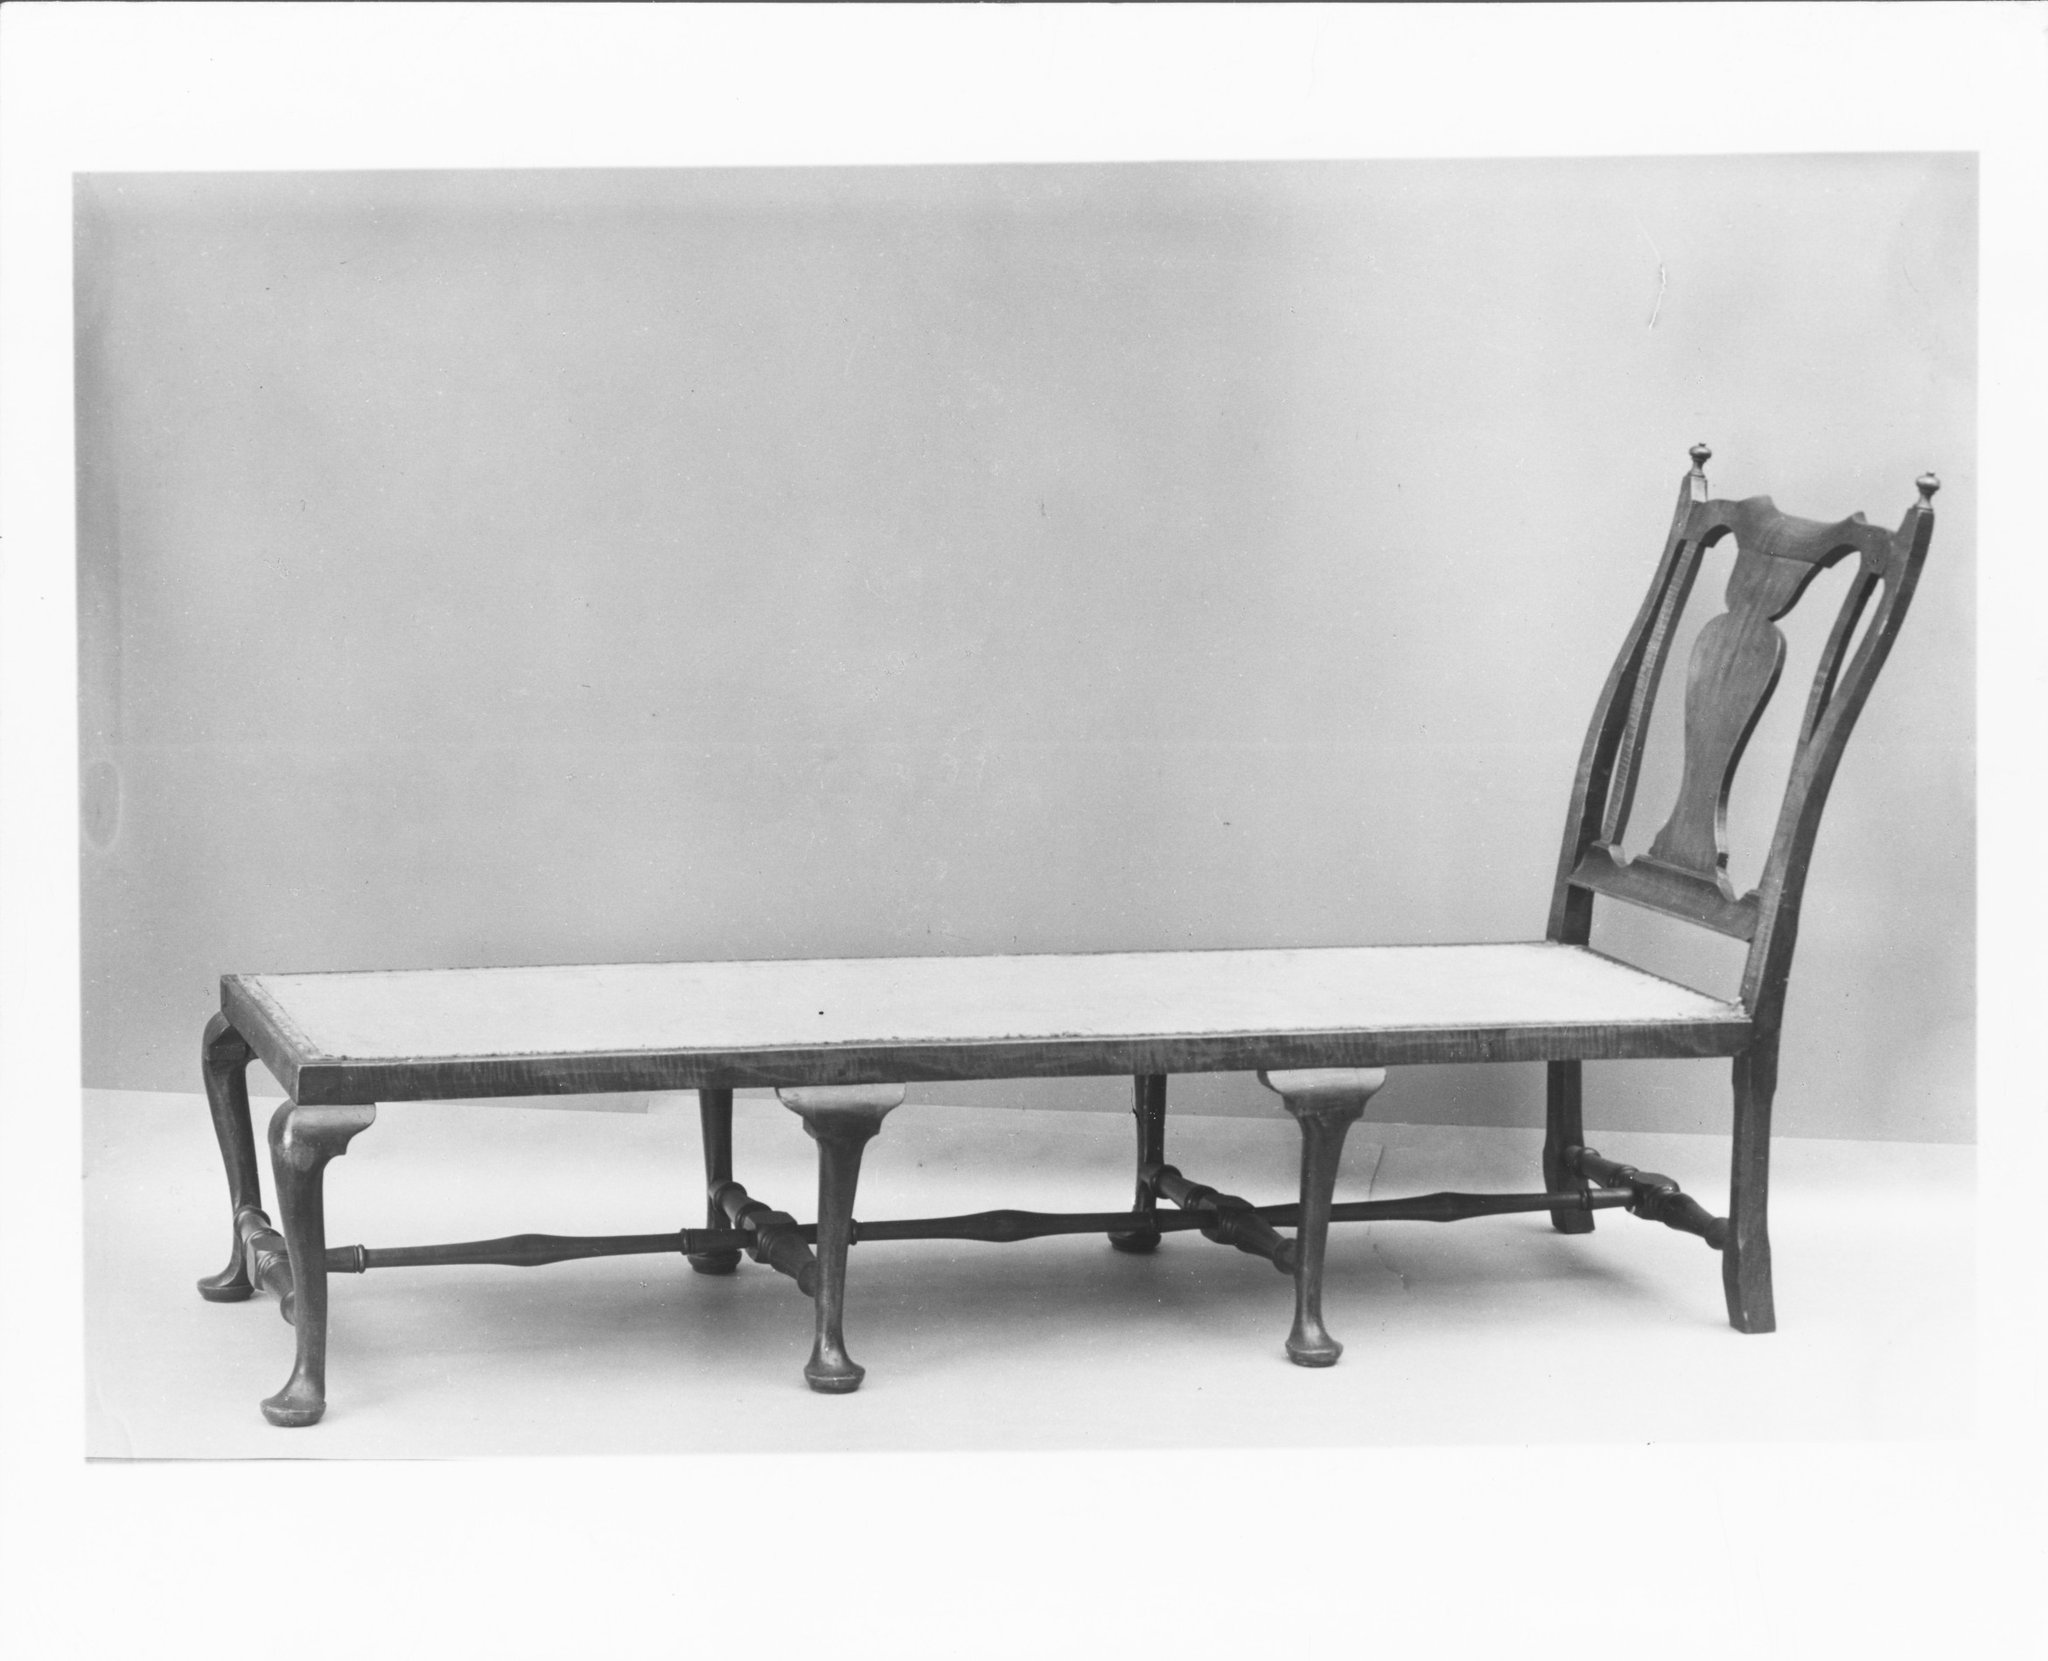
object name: daybed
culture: american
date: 1740-1790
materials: wood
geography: united states